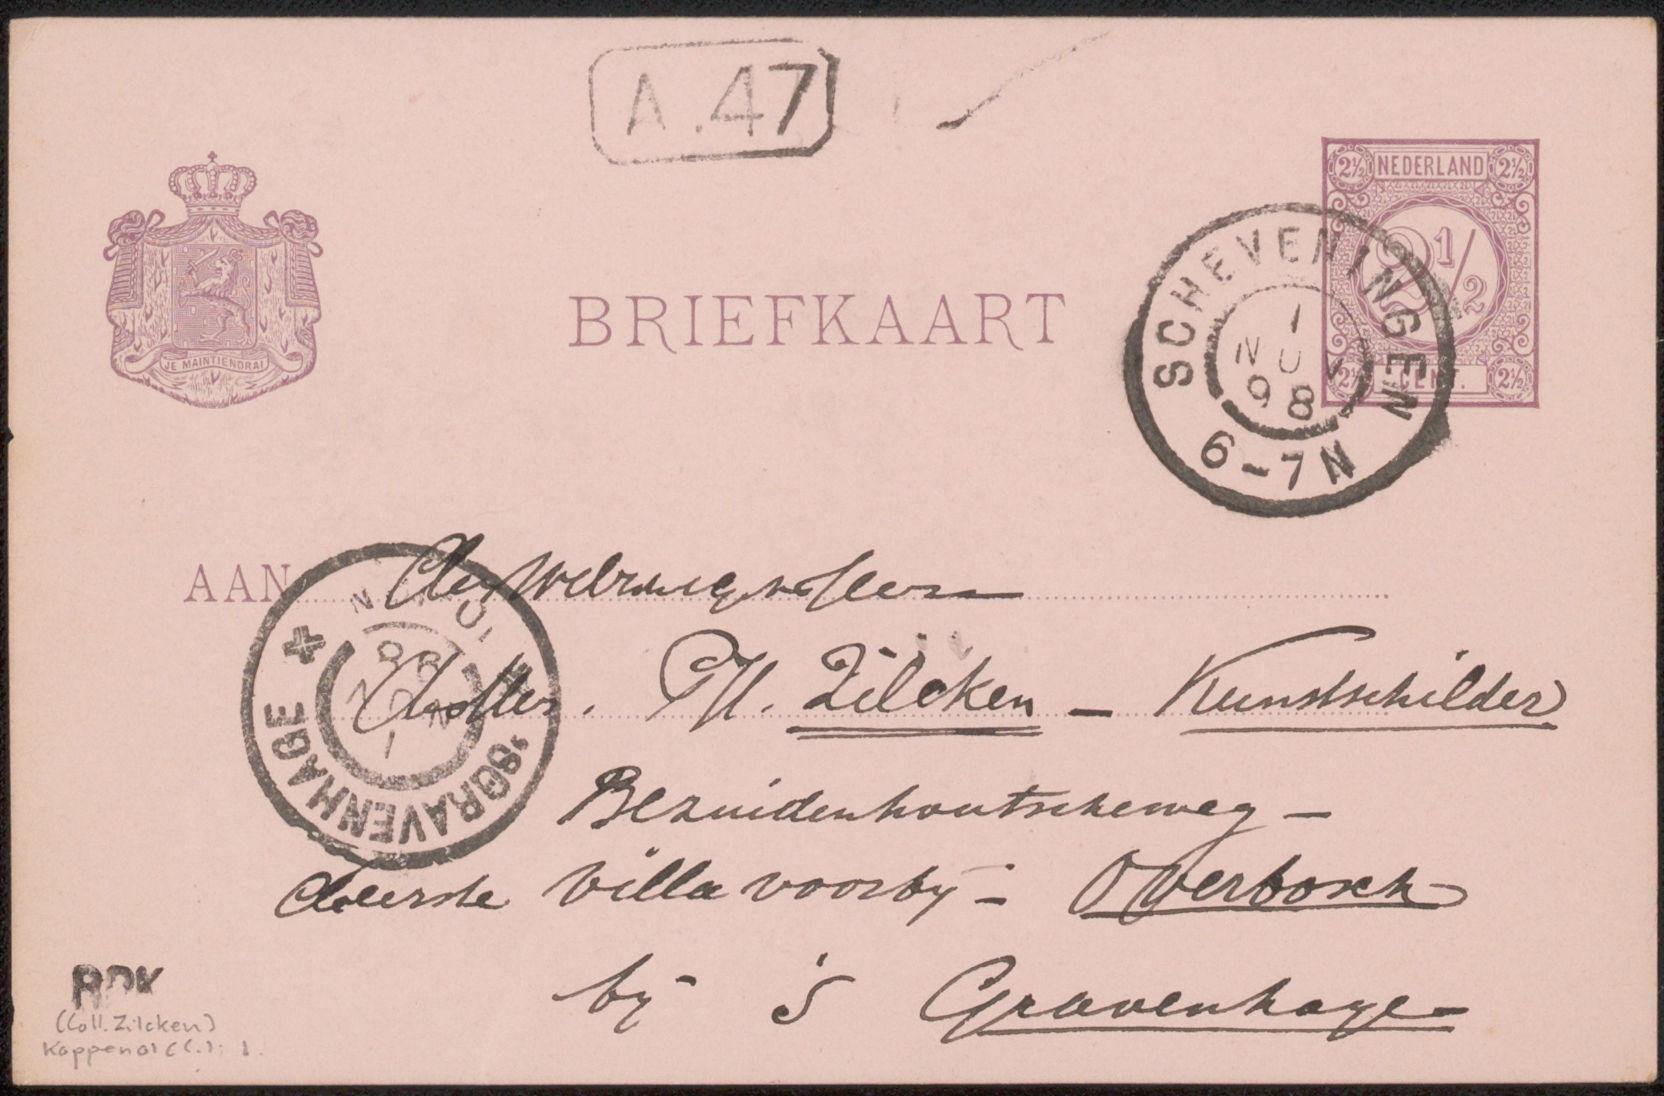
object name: postcard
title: Briefkaart aan Philip Zilcken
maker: cornelis koppenol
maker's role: print maker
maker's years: 1865-1946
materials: cardboard, ink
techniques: pen, writing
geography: scheveningen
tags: the hague, painter, draughtsman, philip zilcken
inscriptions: collector's mark: ‘RPK’